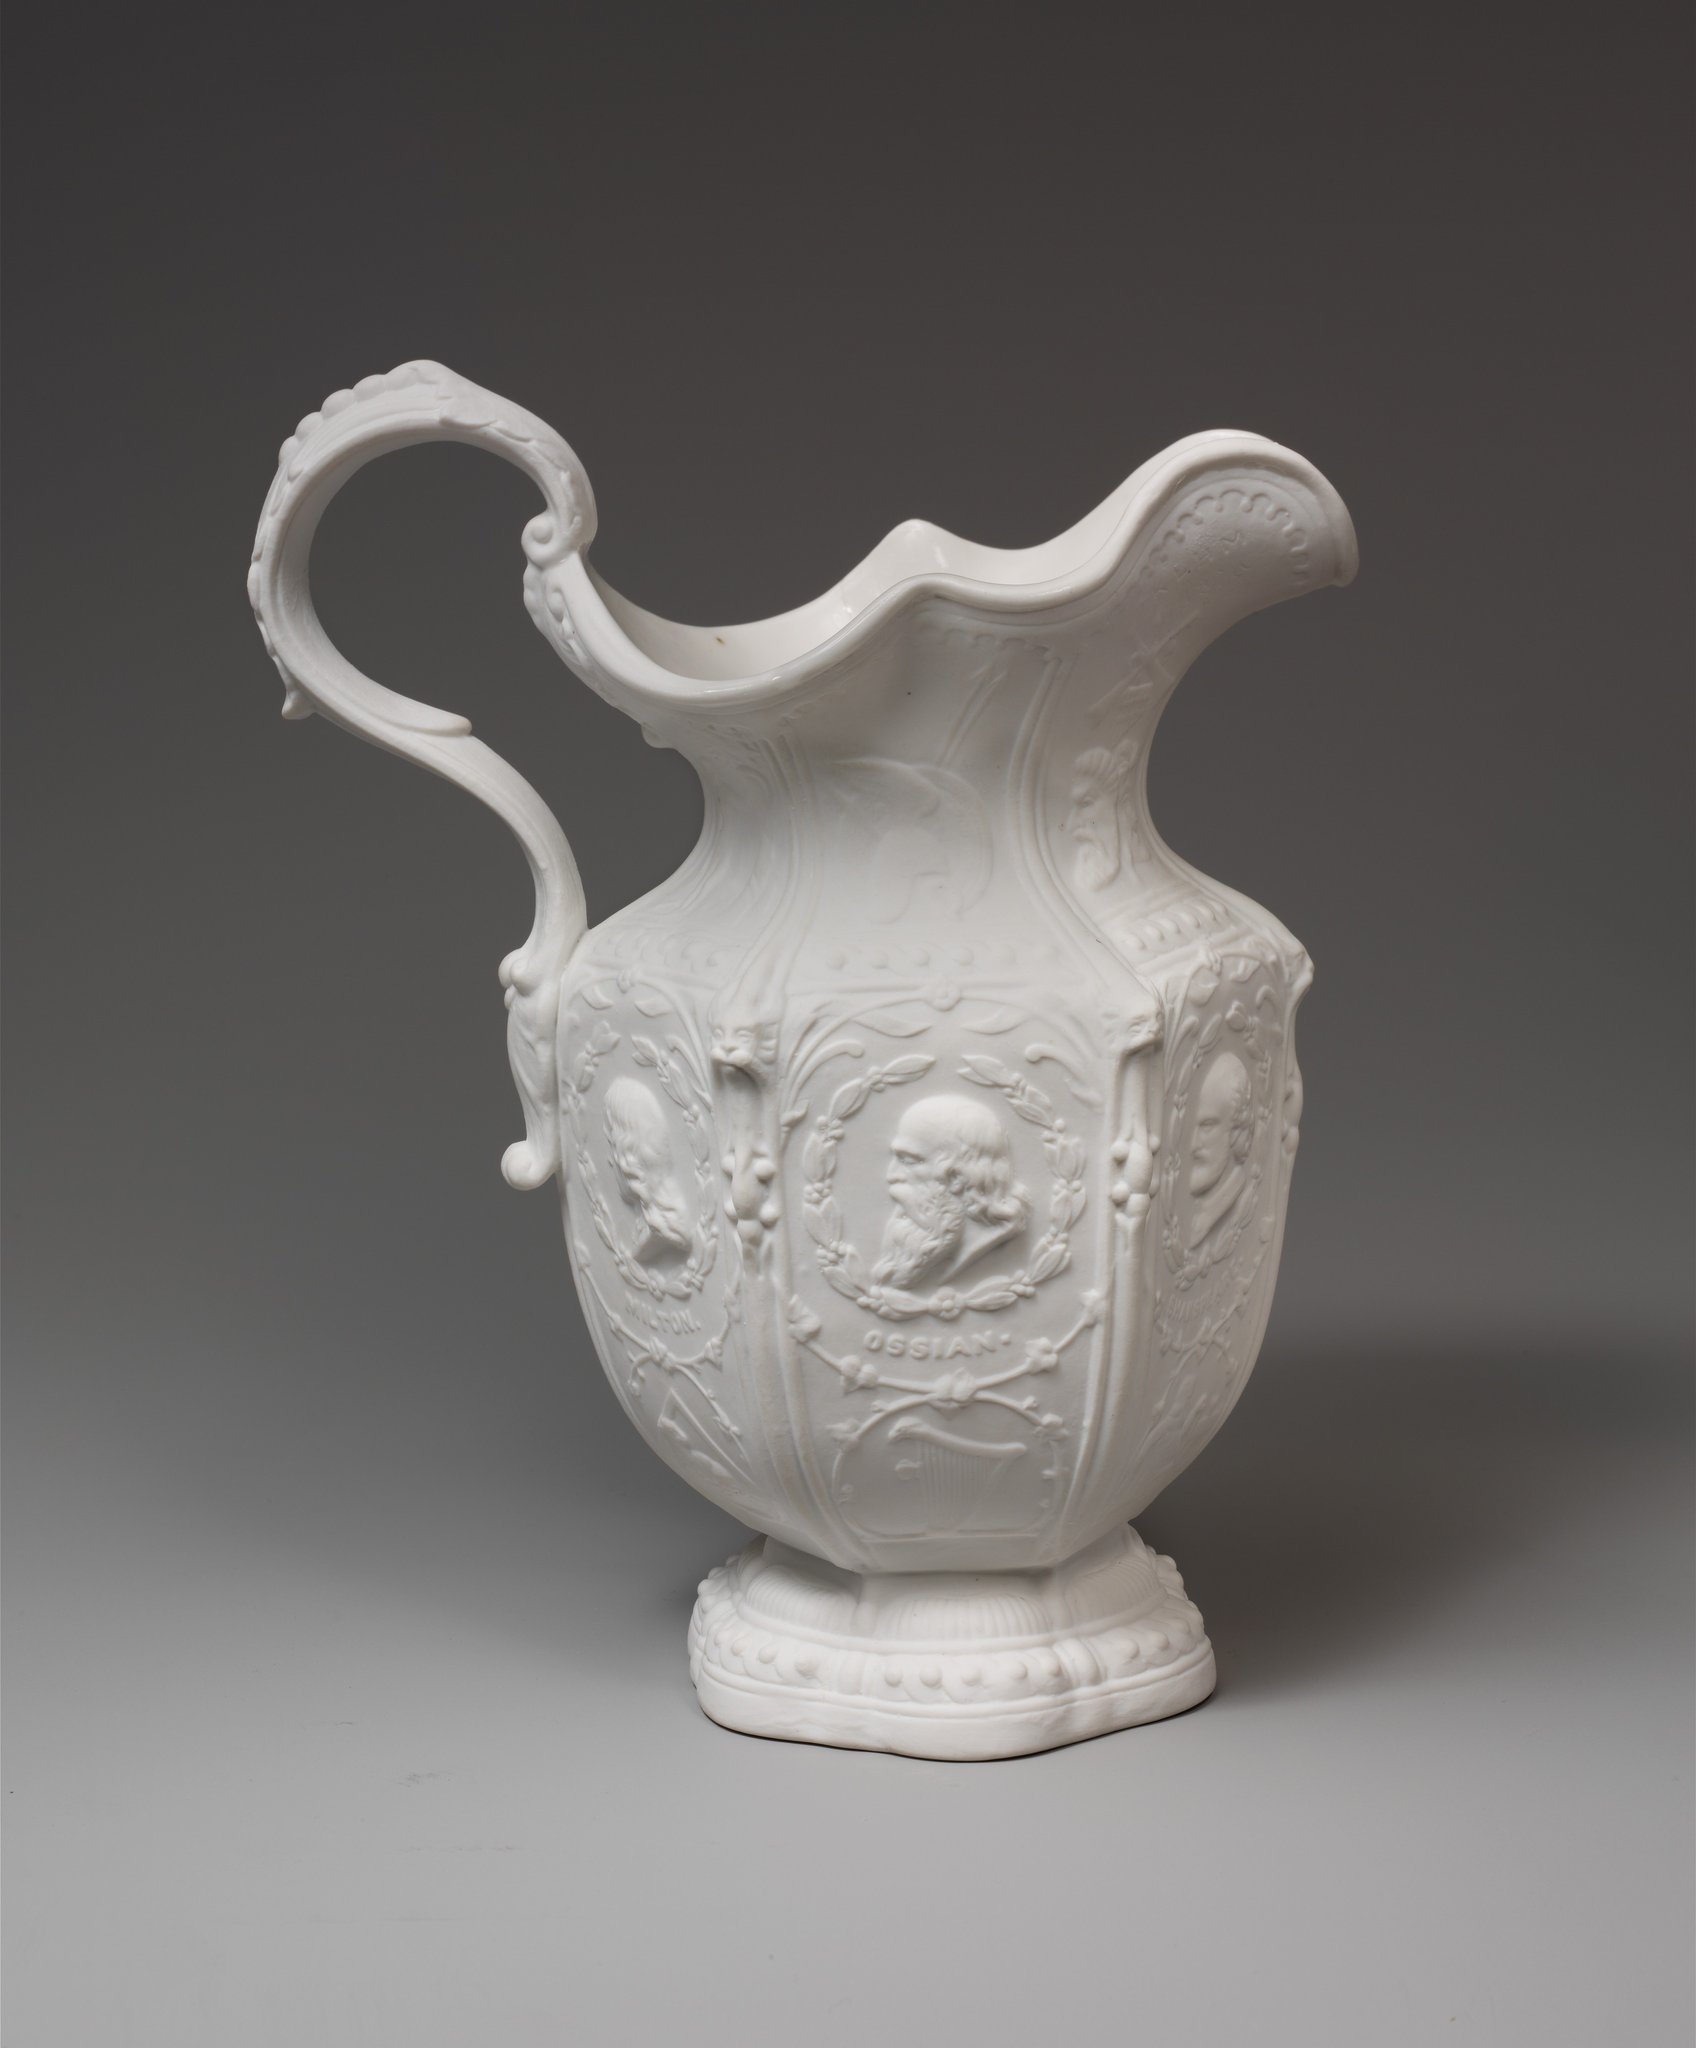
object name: pitcher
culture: american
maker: karl l. h. müller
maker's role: designer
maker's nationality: american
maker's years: 1820-1890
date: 1875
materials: porcelain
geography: united states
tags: men,profiles